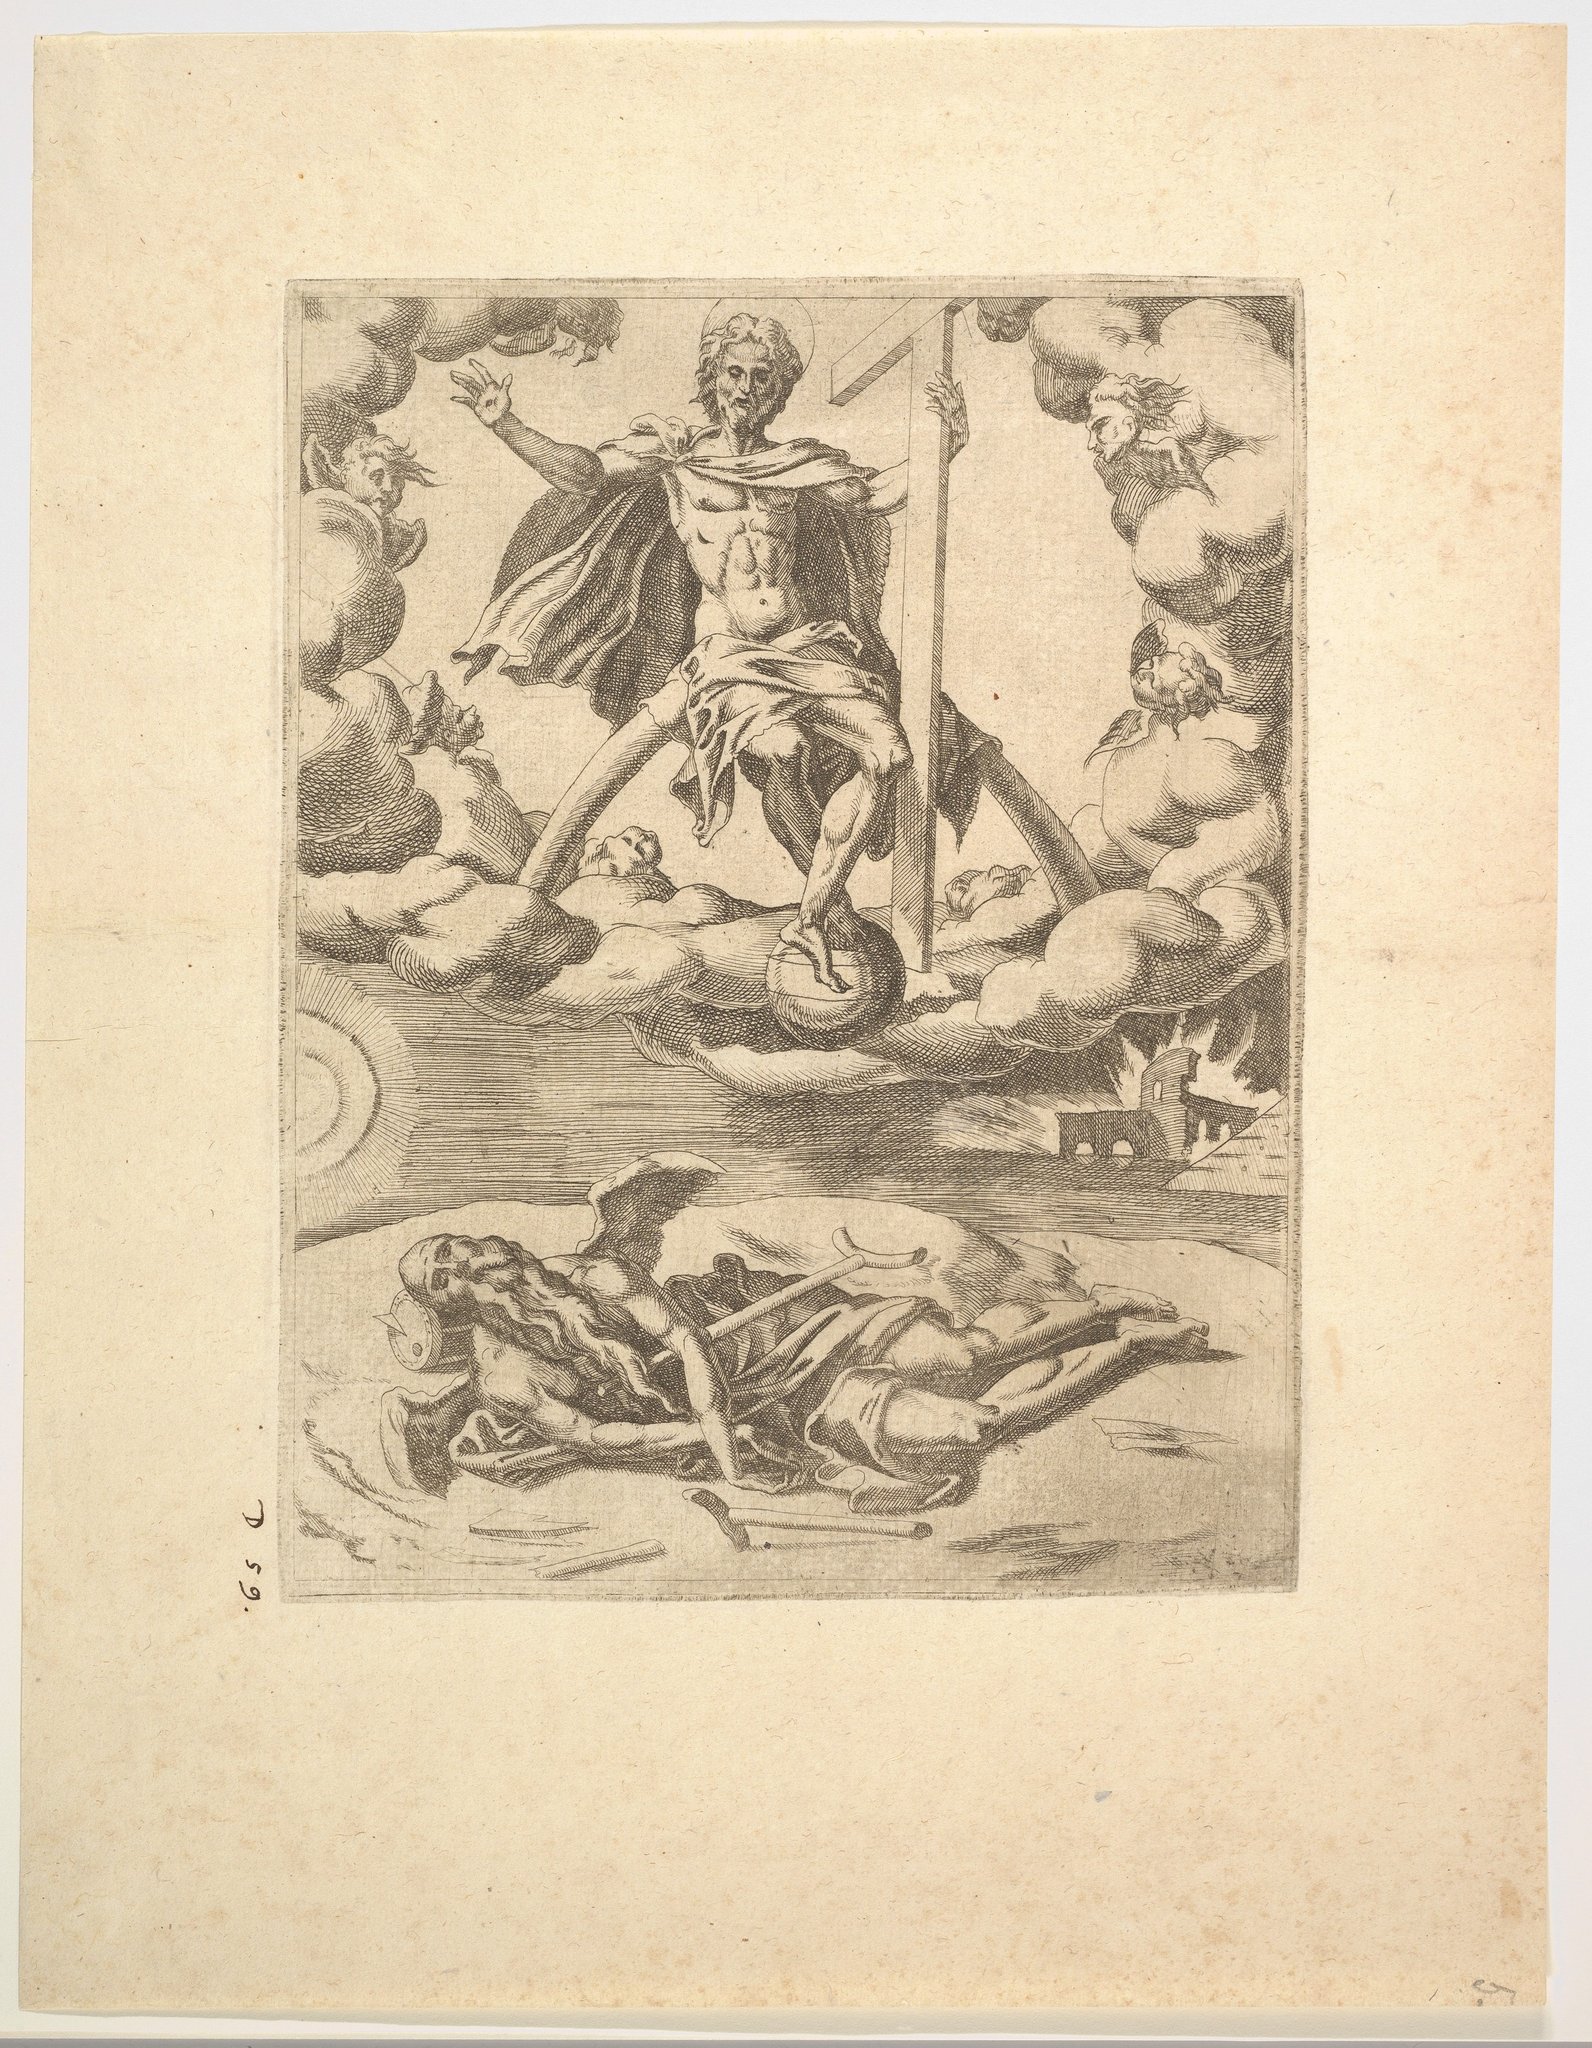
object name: print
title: The Triumph of Divinity or Eternity from The Triumphs of Petrarch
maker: dirck volckertsz coornhert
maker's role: artist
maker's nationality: netherlandish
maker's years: 1519-1590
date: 1548-1549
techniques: etching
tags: men,christ